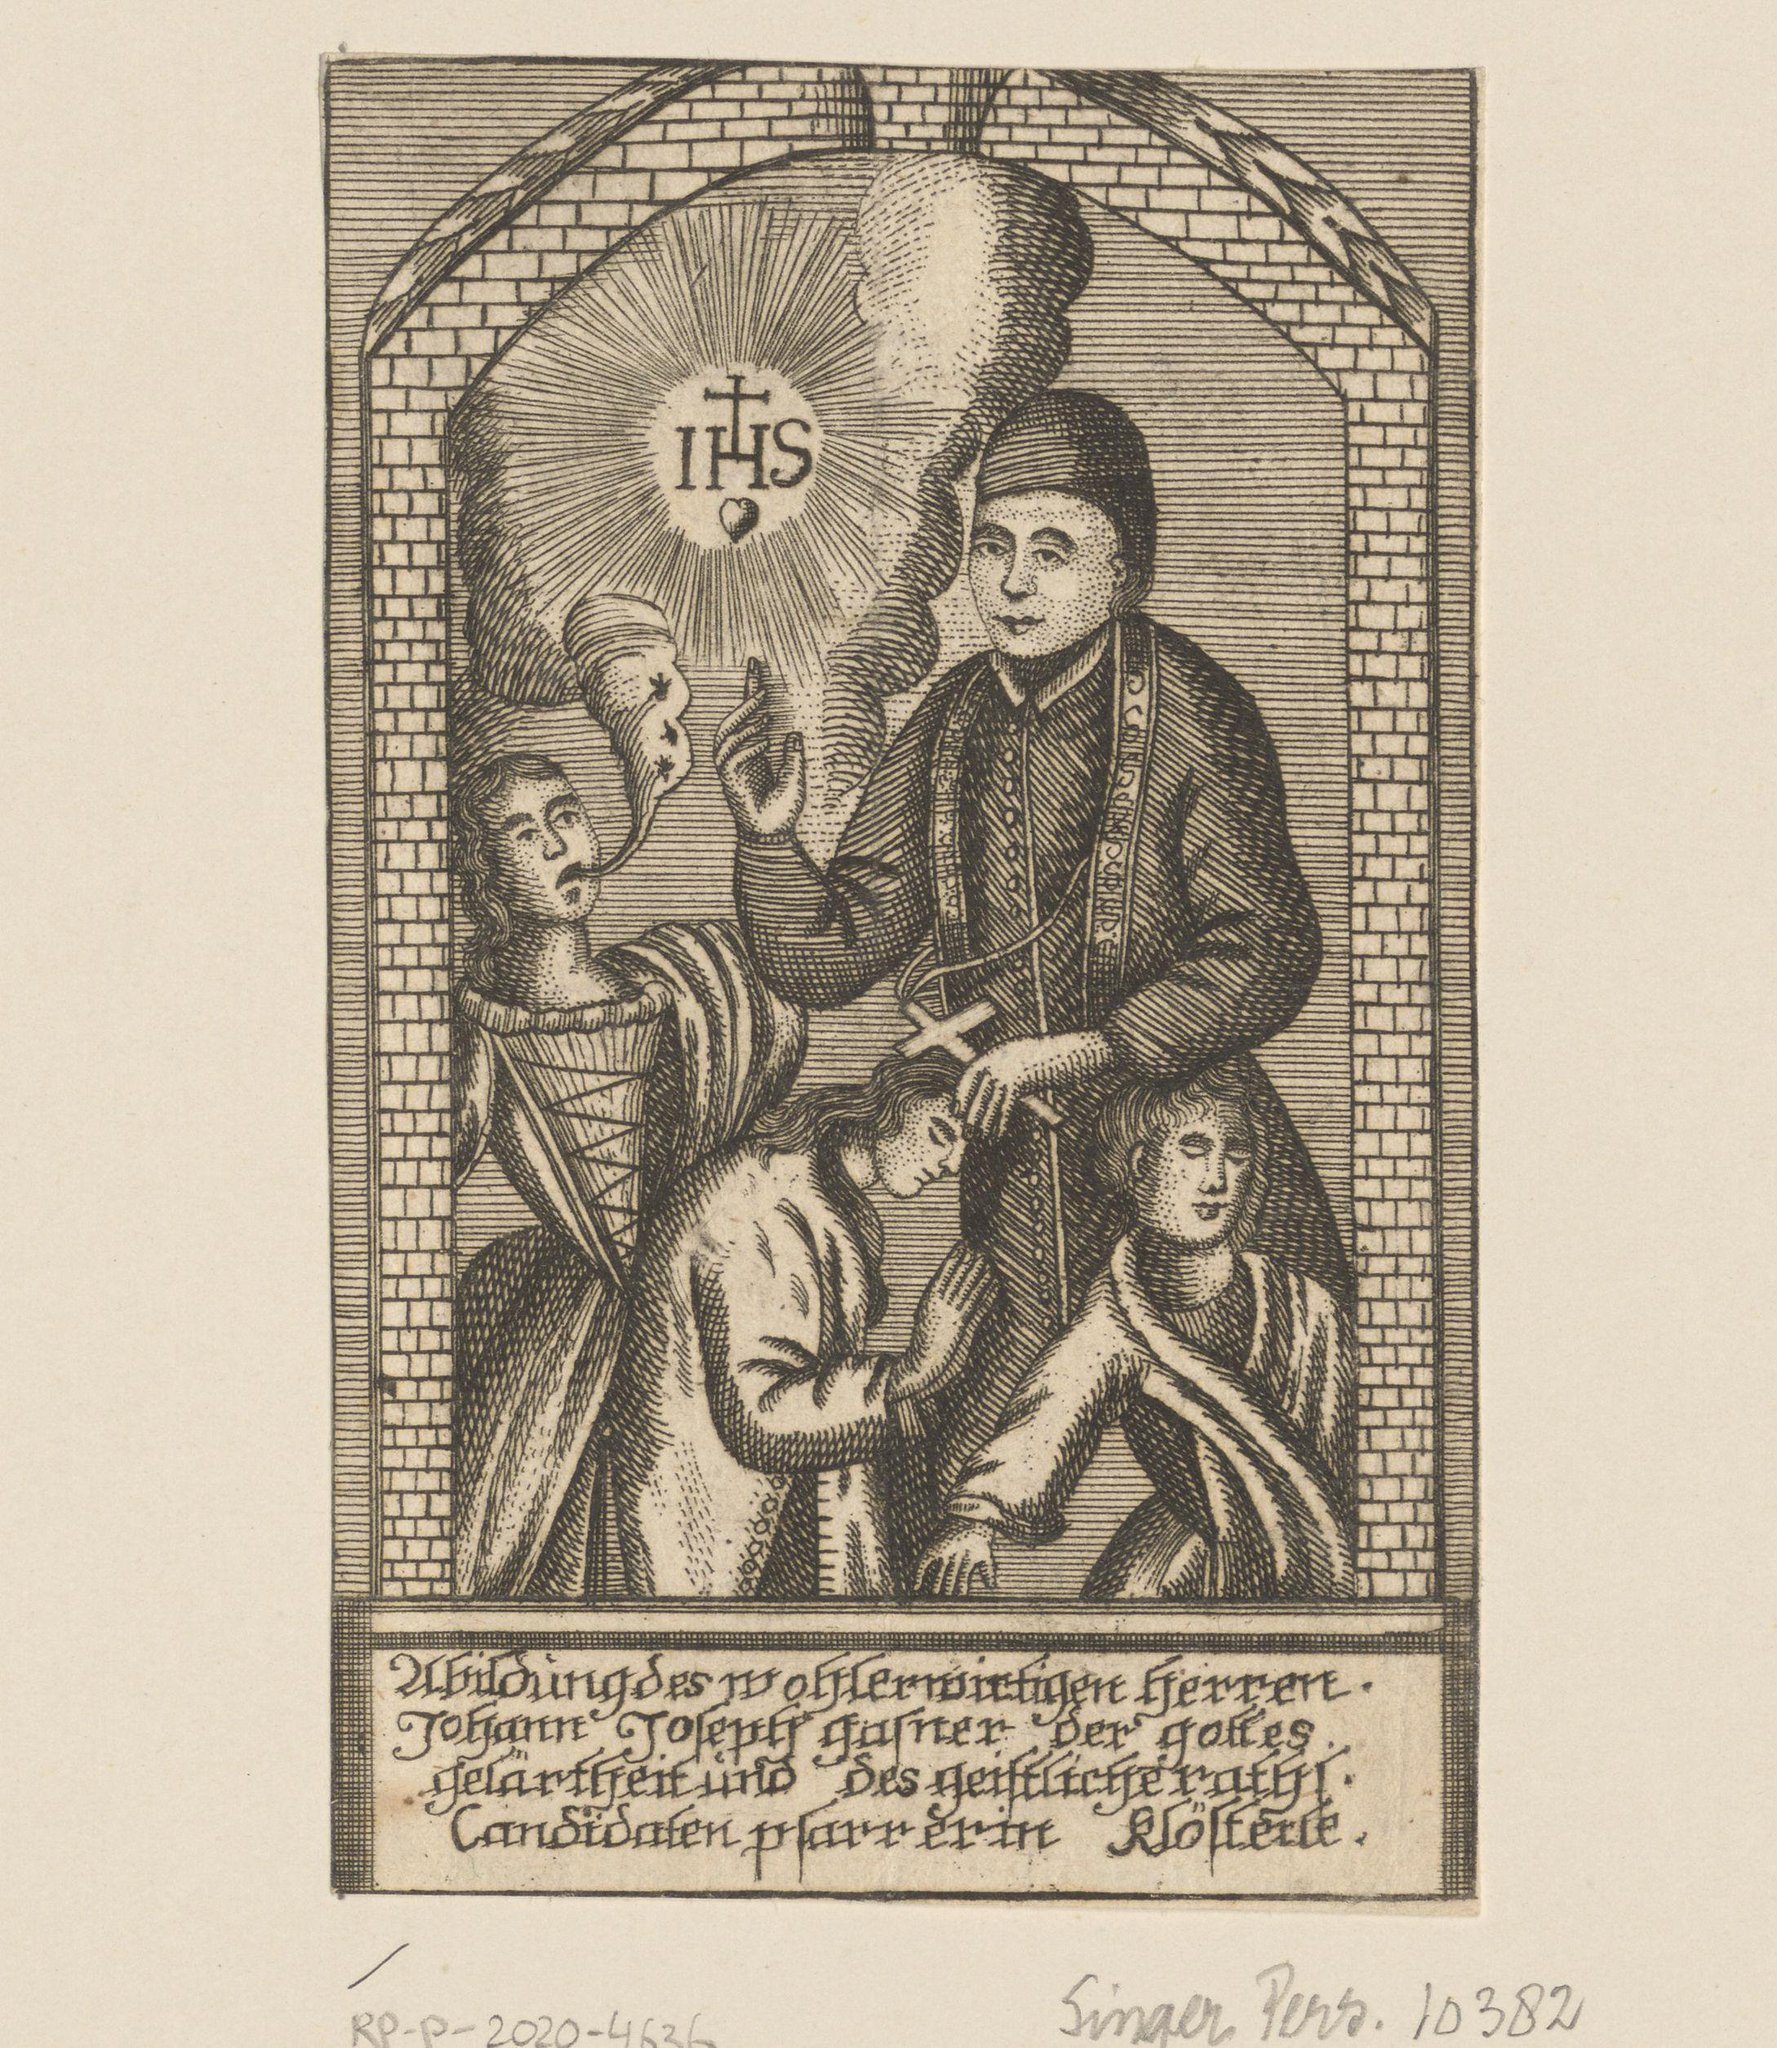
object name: print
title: Portret van Johann Joseph Gassner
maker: Anonymous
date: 1750-1779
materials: paper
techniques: engraving, etching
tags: theologian, historical persons